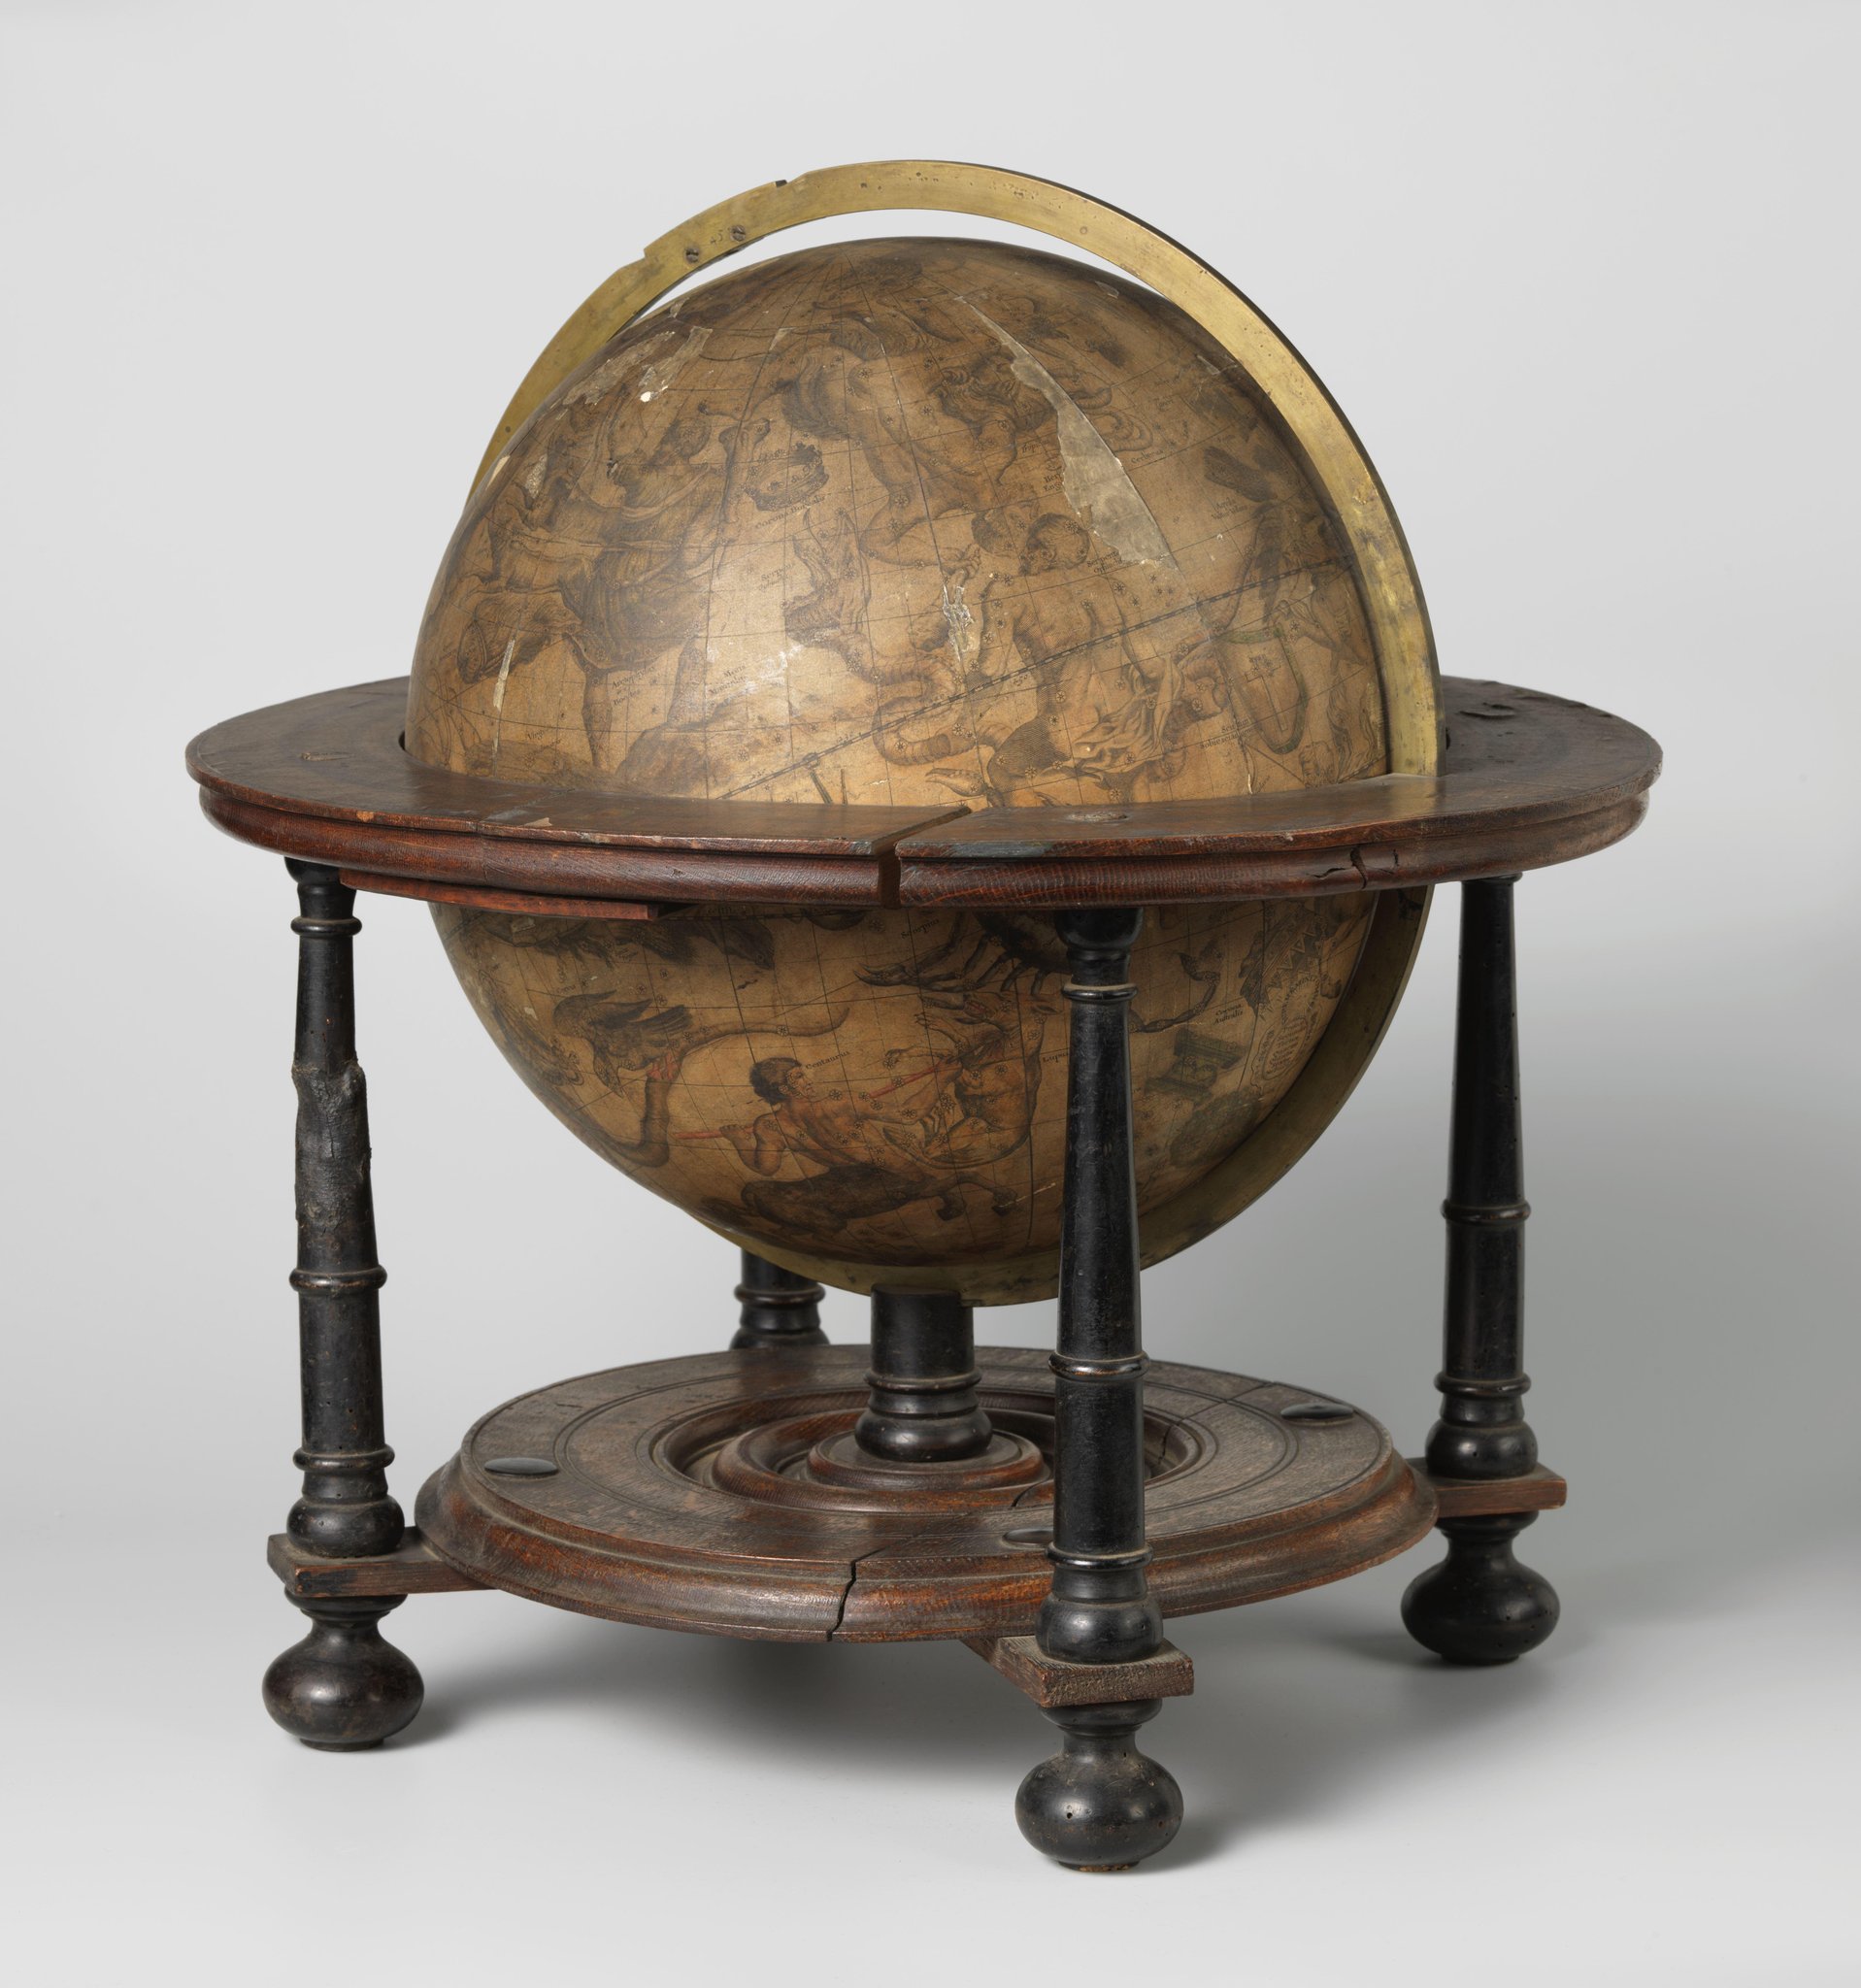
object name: hemelglobe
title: Hemelglobe in houten stoel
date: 1700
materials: copper, gypsum, wood, paper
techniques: woodworking, casting, colour, forging, printing, striking, turning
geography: amsterdam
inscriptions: date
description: Hemelglobe in houten stoel. De stoel heeft vier poten, onder een rond geprofileerd blad met in het midden een korte houten as waarin een gleuf, waarin koperen graadboog die om de bol zit, valt. Bovenaan de poten een horizontale houten cirkel waar de bol half bovenuitsteekt en waarop een kalender, thans bijna onleesbaar, is geplakt. De figuren van de sterrebeelden op de globe zijn geheel uitgetekend en ingekleurd. Op de onderste helft een lofrede aan het adres van Lotharius Zum-Bach. Opschrift. Gedat. Gesig.